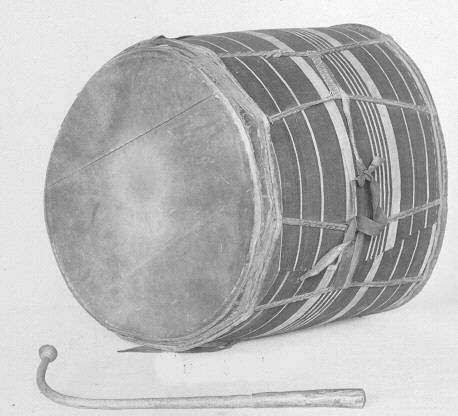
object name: ganga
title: Ganga?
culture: dagomba or hausa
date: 1801-1900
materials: textile, cord, wood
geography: ghana